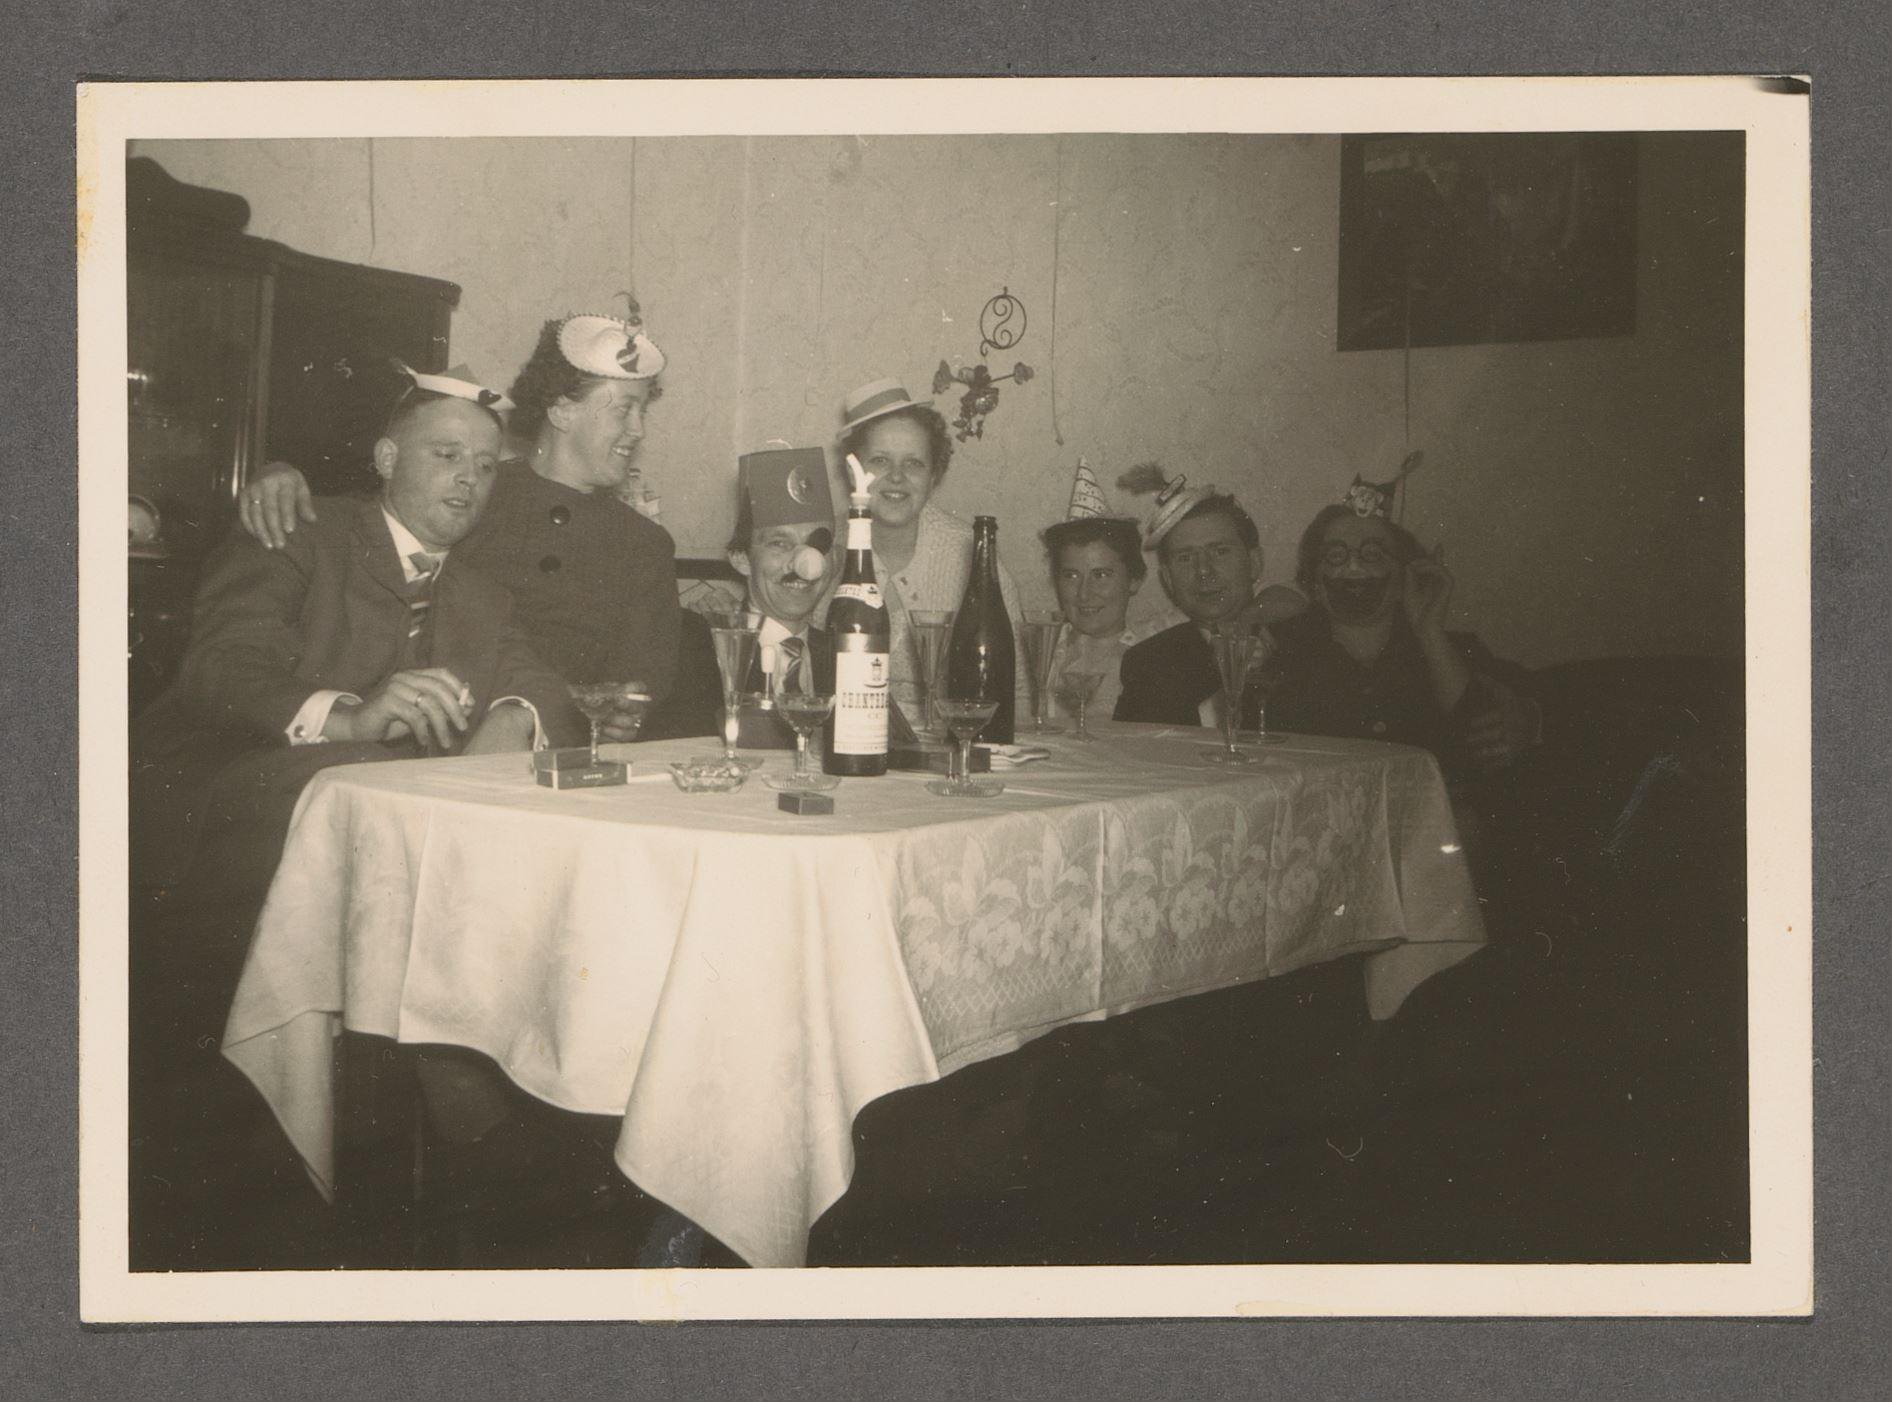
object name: photograph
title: Mannen en vrouwen aan tafel op een feest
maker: Anonymous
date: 1930-1950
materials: paper, photographic support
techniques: gelatin silver print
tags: adult woman, adult man, festivities